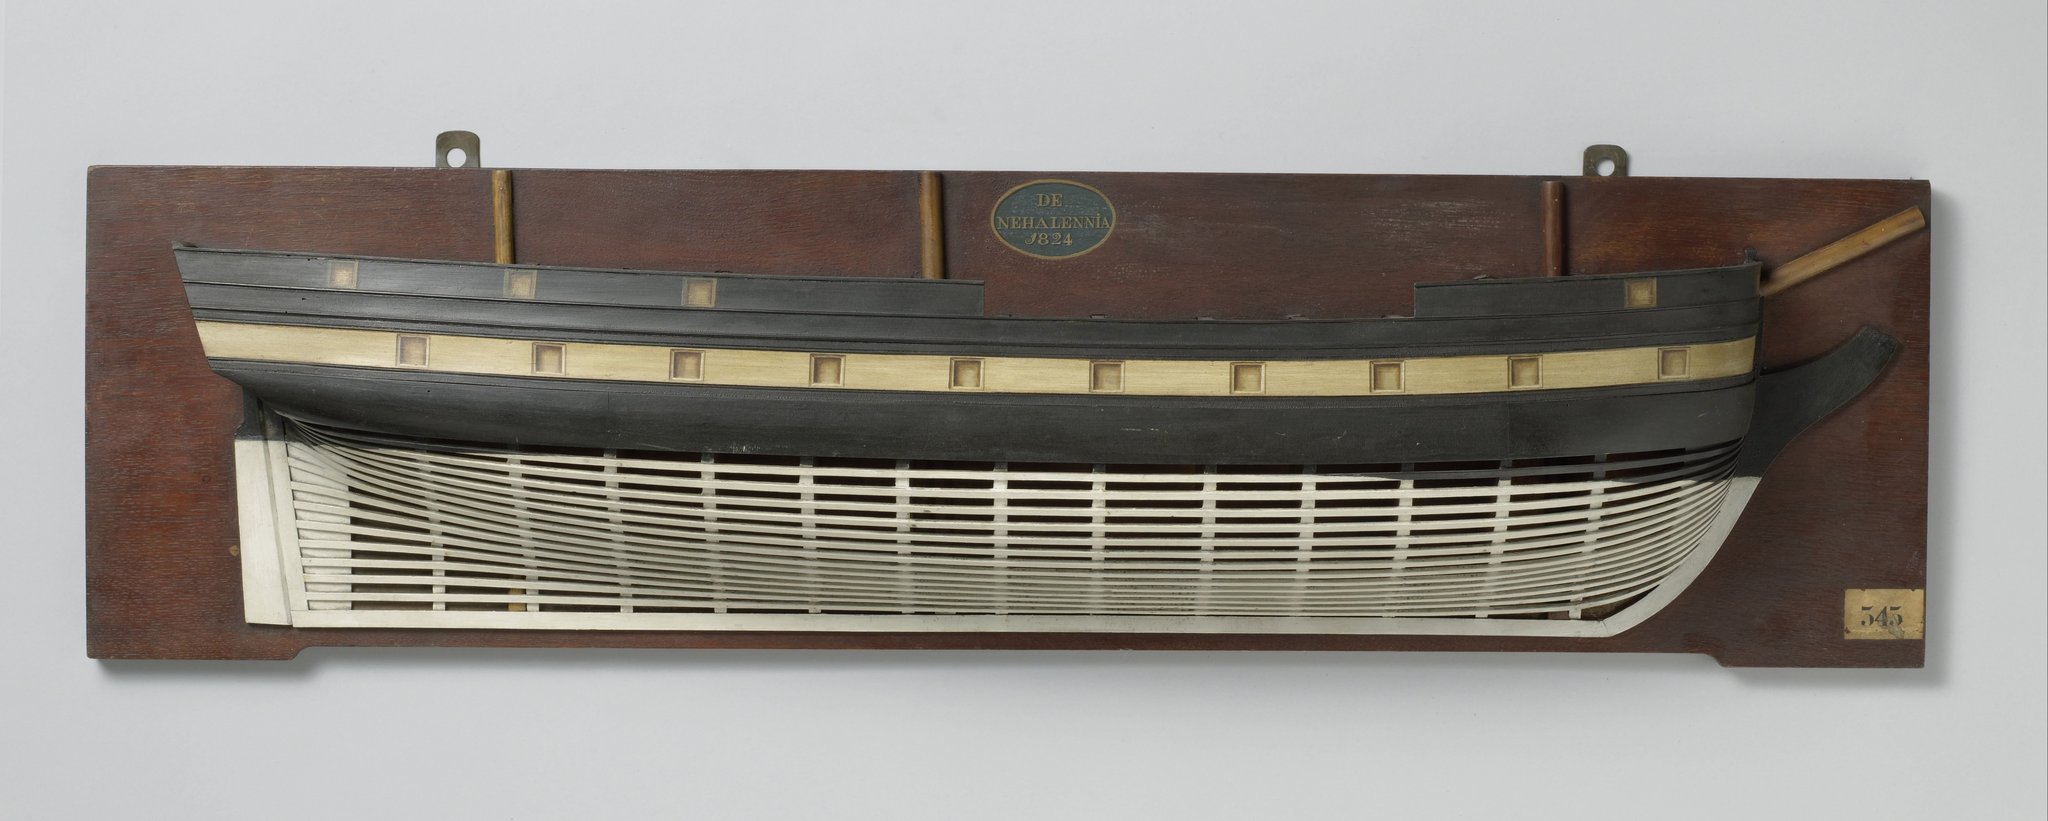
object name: builder's model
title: Half Model of a 28-Gun Sloop of War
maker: Anonymous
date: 1824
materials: wood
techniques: polychromy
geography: netherlands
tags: nehalennia (schip)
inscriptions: inscription, top centre, on a blue roundel, painted: ‘DE / NEHALENNIA / 1824’, label, bottom right: ‘343’ former inventory label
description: Gepolychromeerd mallenmodel (stuurboord) van een driemaster, de huid boven het barkhout gesloten. Veertien geschutpoorten verdeeld over twee dekken, halfdek en bakdek door gillingen aangegeven. Gewrongen spiegel, hol wulf, hek gesloten maar niet uitgewerkt, geen zijgalerij: roer met vierkante roerkoning en roerblad afgerond op de waterlijn. Zeeg naar voor en achter oplopend, één barkhout en twee reehouten. Gepiekt rondspant. Schaal 1:40 (afgeleid).